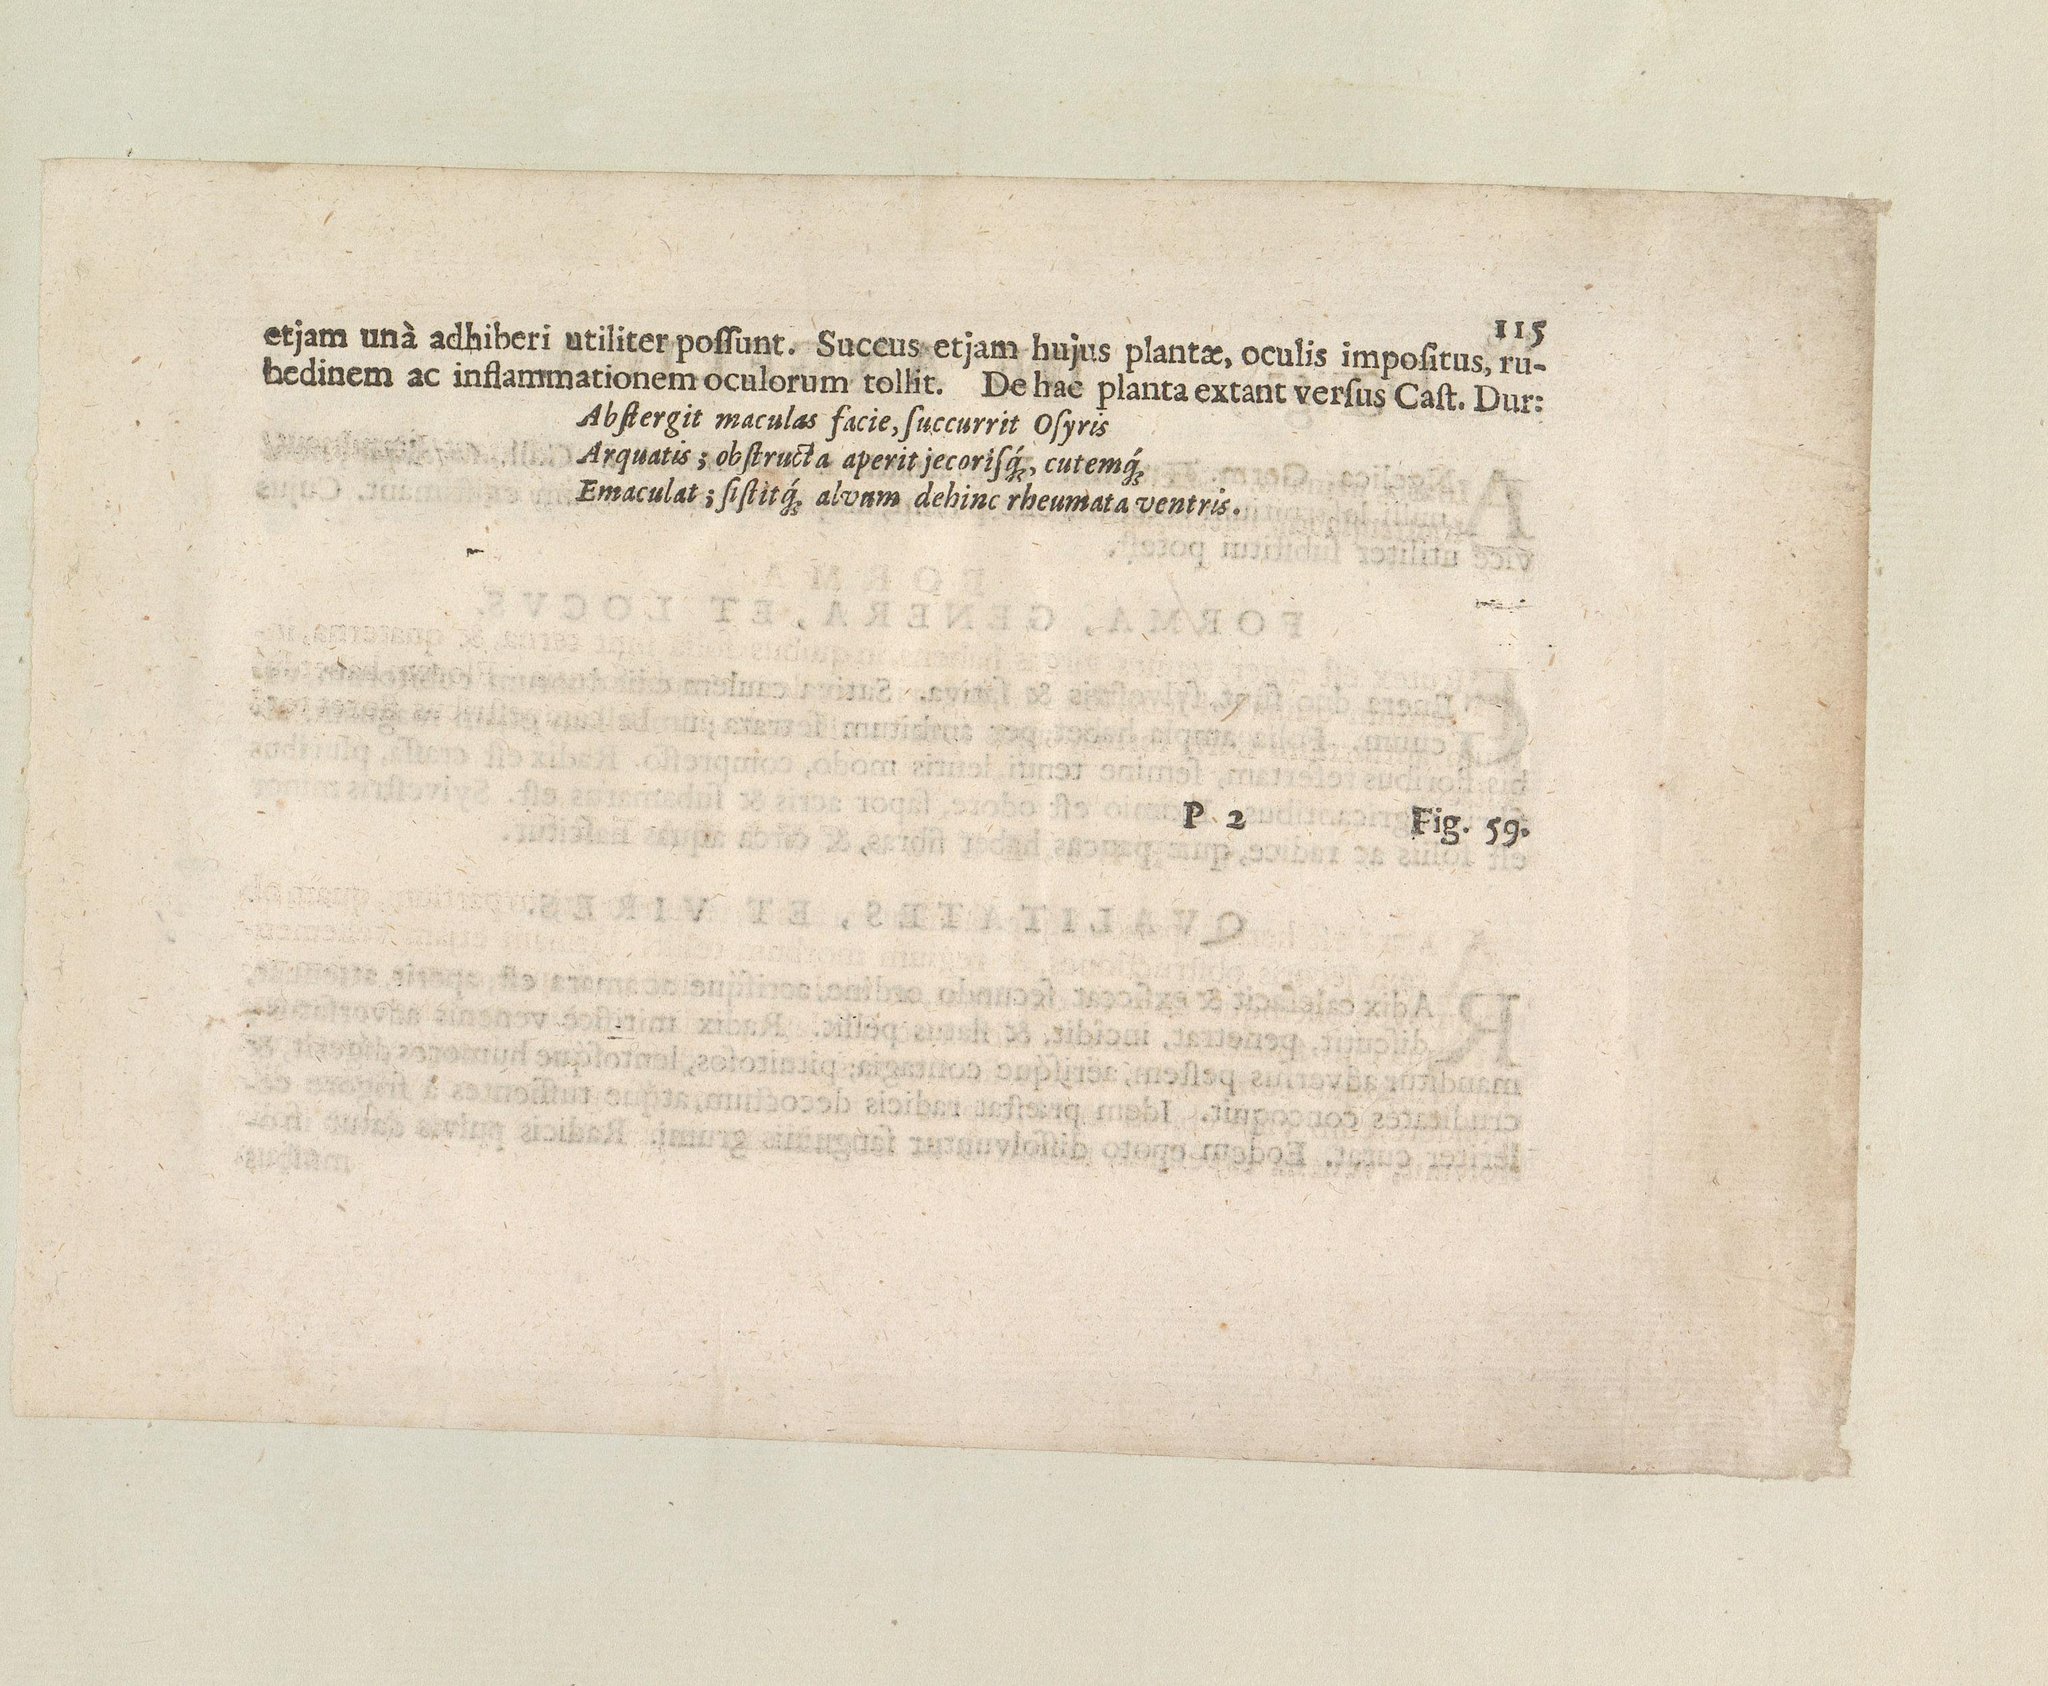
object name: text sheet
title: Fig. 58 'De Linaria' in De Boodts herbarium van 1640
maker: anselmus boëtius de boodt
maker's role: draughtsman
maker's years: 1550-1632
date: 1640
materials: ink, paper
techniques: letterpress printing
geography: bruges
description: Beschrijving bij Fig. 58 op p. 115 in: Anselmi Boëtii de Boot I.C. Brugensis & Rodolphi II. Imp. Roman. medici a cubiculis Florum, Herbarum, ac fructuum selectiorum icones, & vires pleraeque hactenus ignotæ. Onderdeel van het album met bladen en platen uit De Boodts herbarium van 1640. Het twaalfde van twaalf albums met aquarellen van dieren, vogels en planten bekend rond 1600, gemaakt in opdracht van keizer Rudolf II.